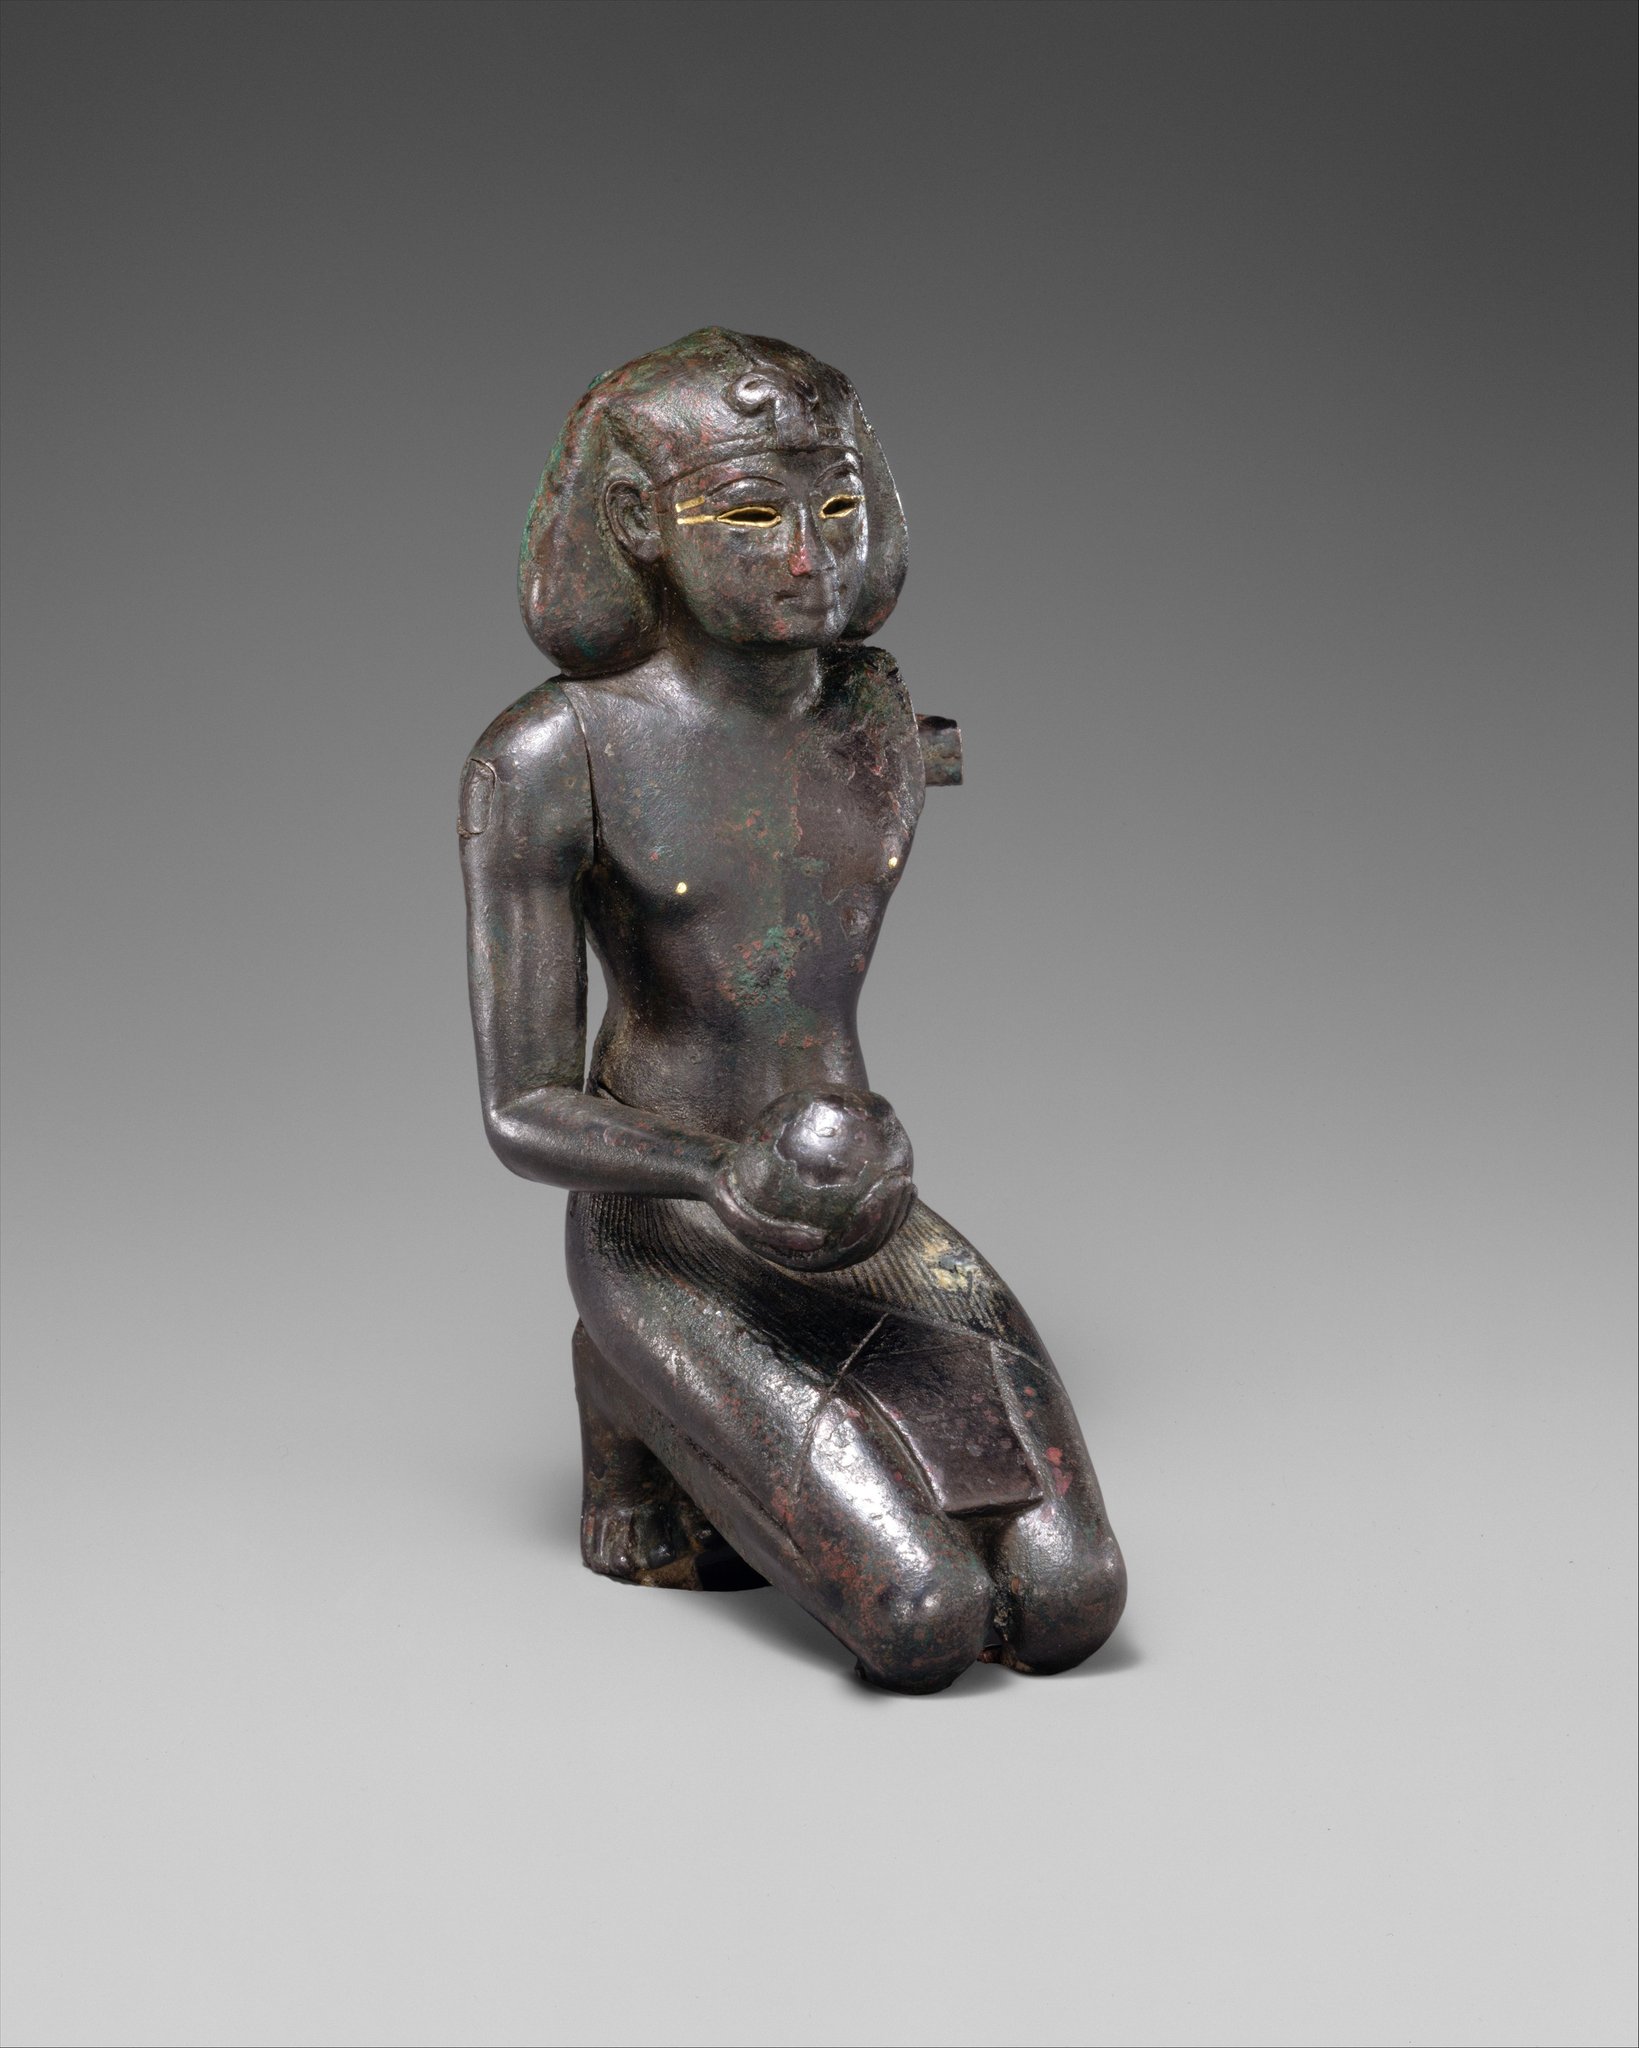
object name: statuette, kneeling king, thutmose iii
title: Ritual Statuette of Thutmose III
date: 1479-1425 BCE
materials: bronze, gold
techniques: inlay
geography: egypt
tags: kings,men